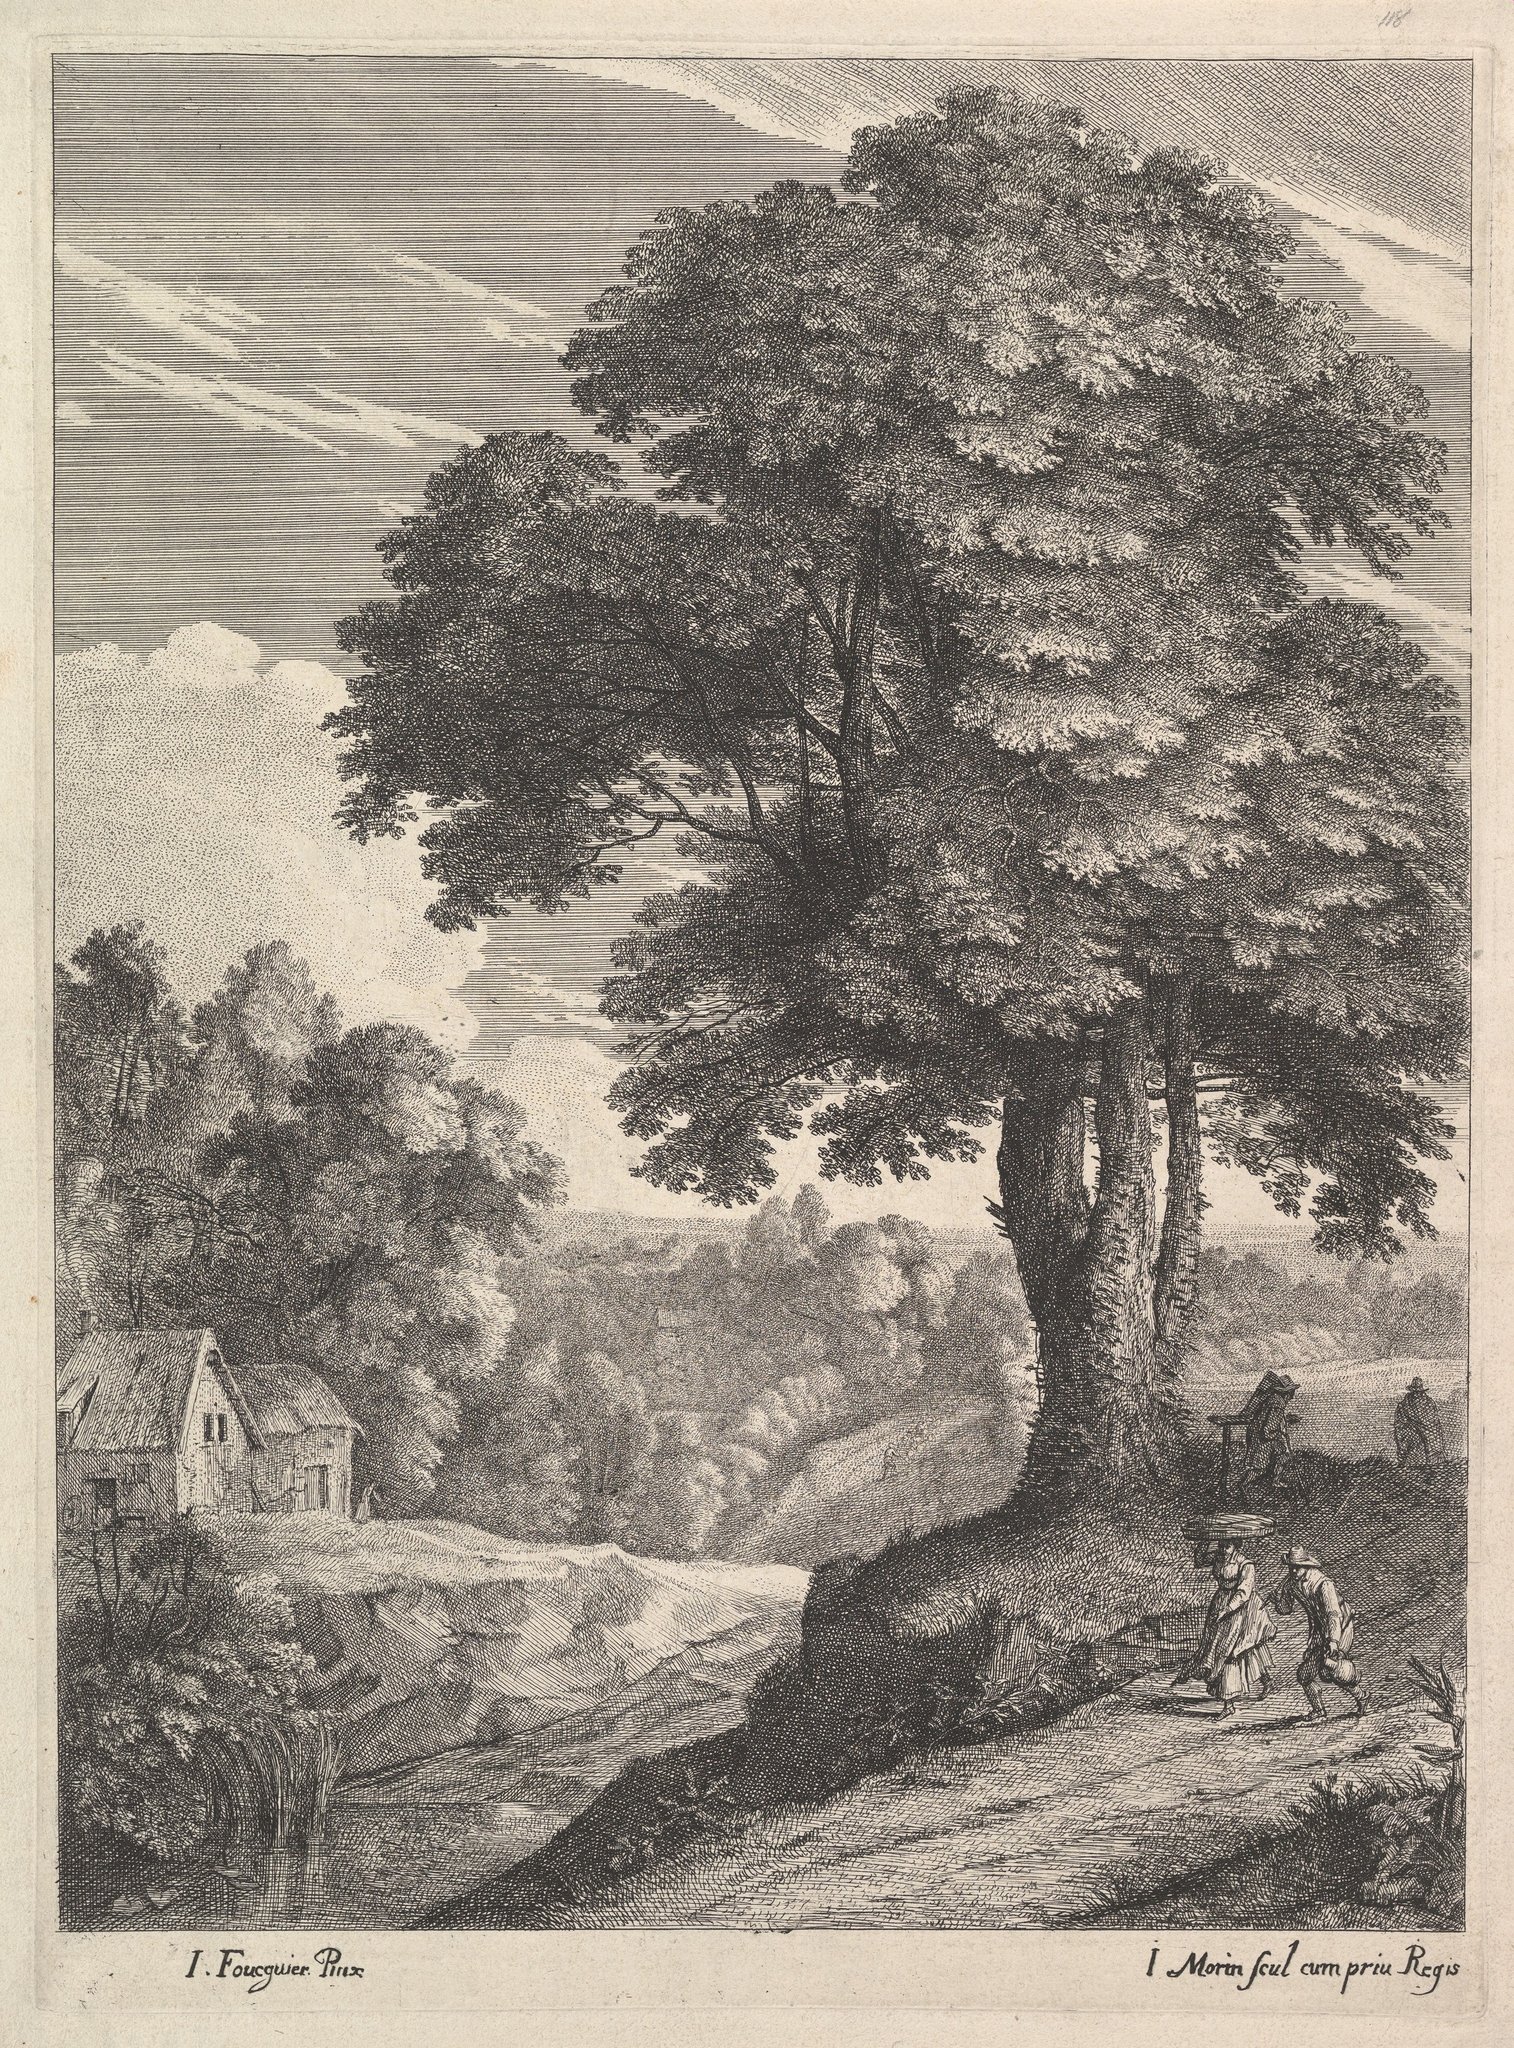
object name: print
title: Les Deux Chaumieres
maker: jean morin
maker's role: artist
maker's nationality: french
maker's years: 1605-1650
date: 1605-1650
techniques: etching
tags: houses,men,women,trees